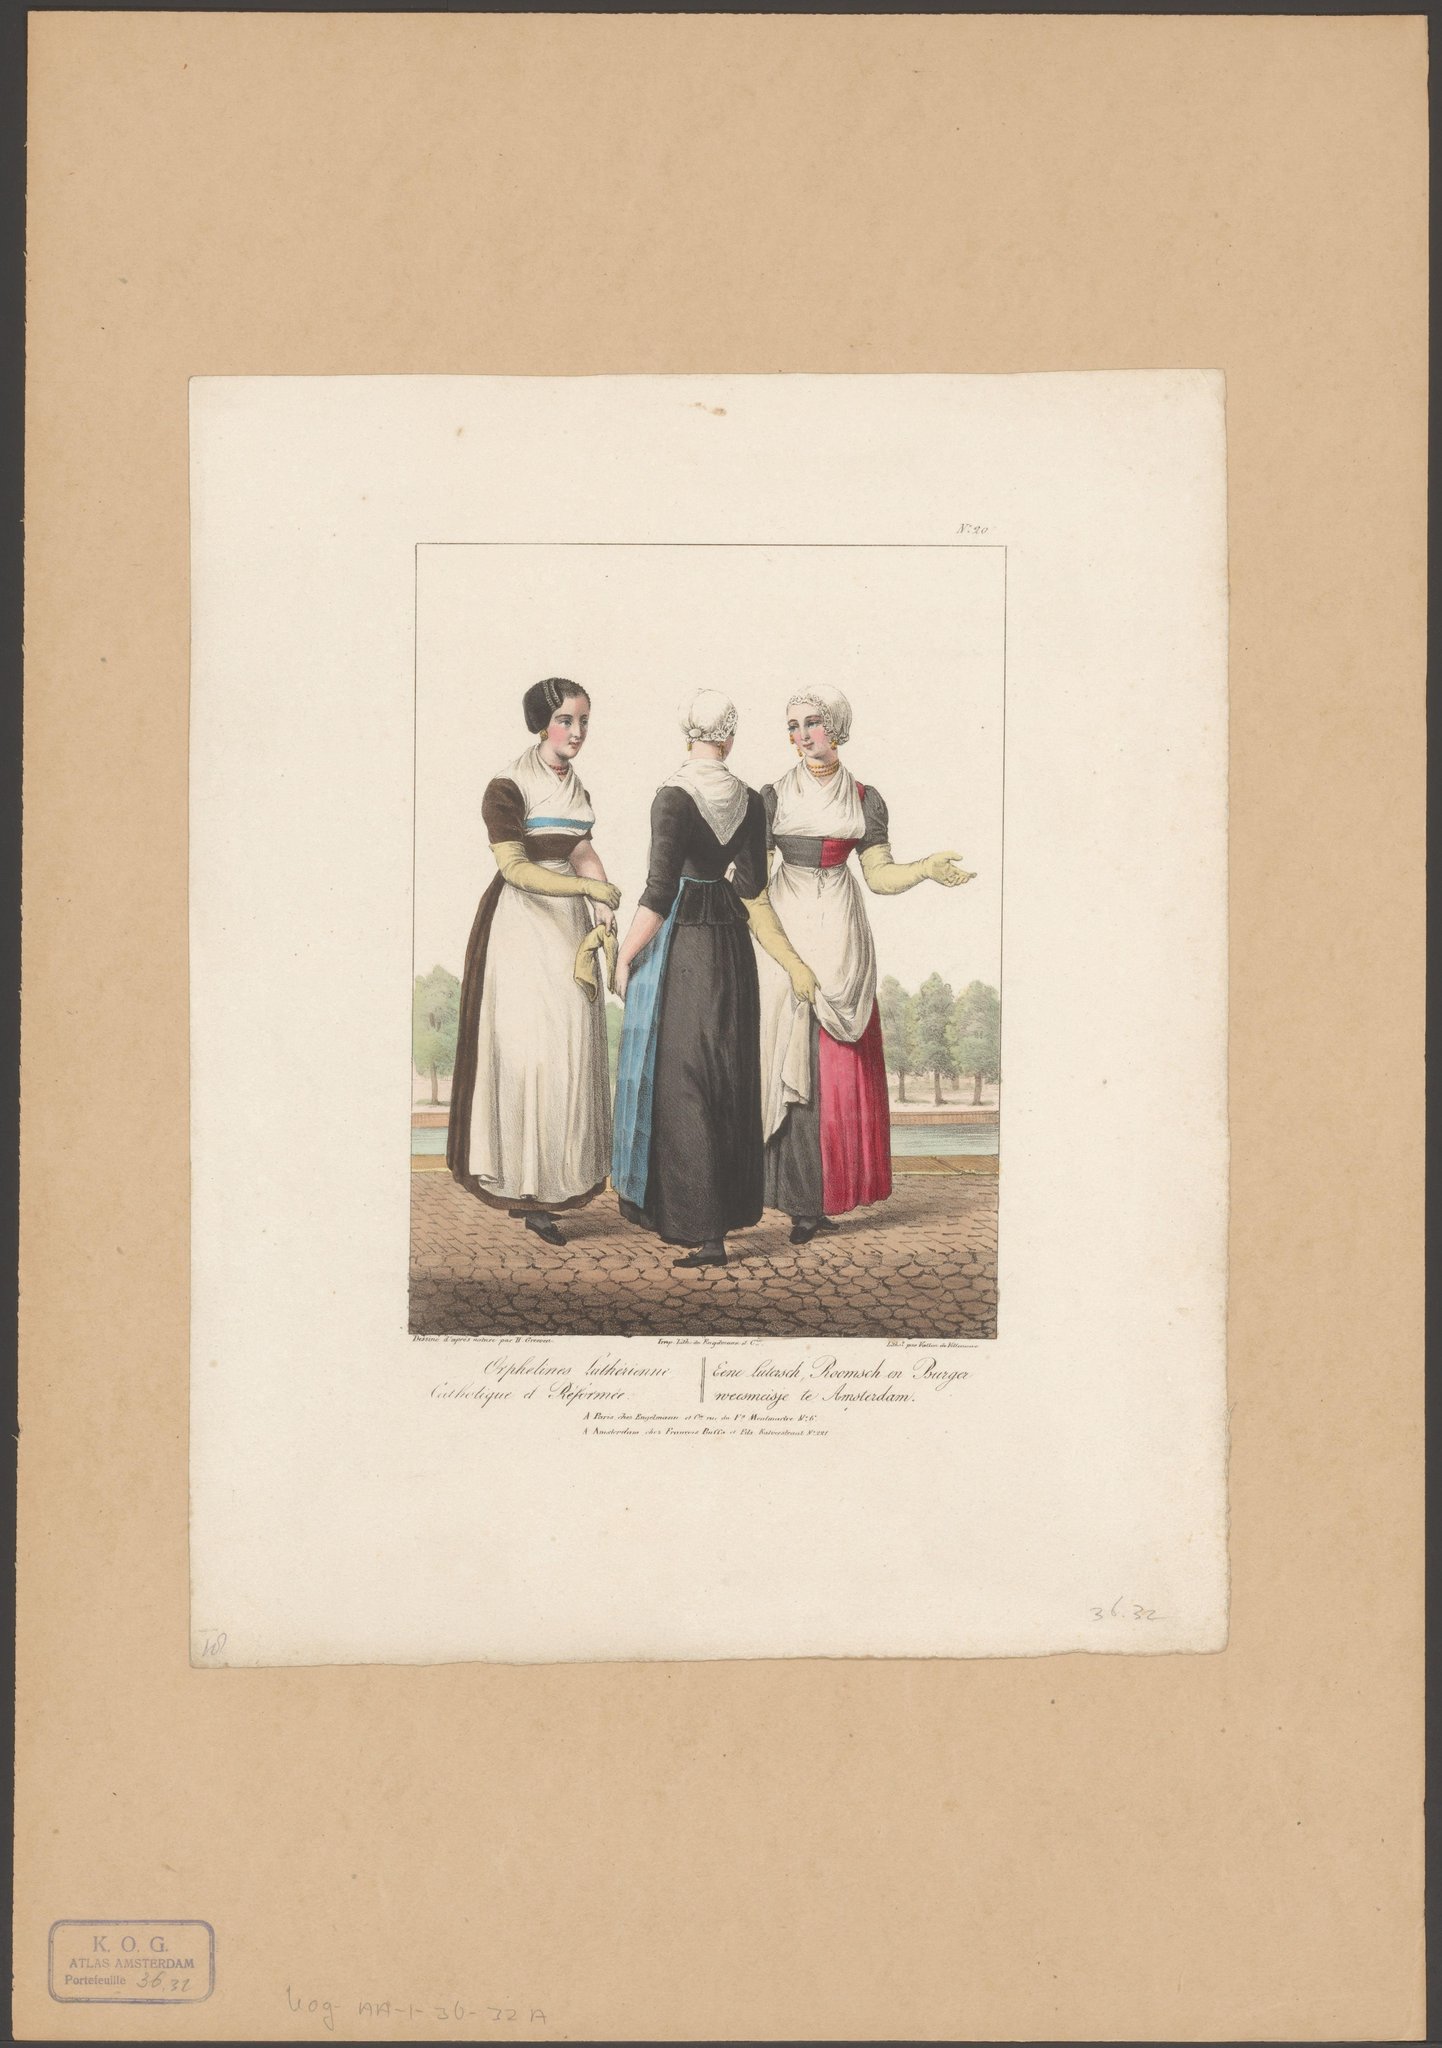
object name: print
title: Orphelines Lutherienne / Cathetique et Réformée / Eene Lutersch, Roomsch en Burger weesmeisjes te Amsterdam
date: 1823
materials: paper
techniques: hand coloring, lithograph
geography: amsterdam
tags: folk costume, regional costume, orphans, amsterdam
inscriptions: collector's mark: Lugt 1641b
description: Rechtsboven genummerd: No. 20. Onderwerpsrubriek binnen de Atlas Amsterdam: Armwezen en liefdadige instellingen: I. Stadsinrichtingen: Verzamelbladen.